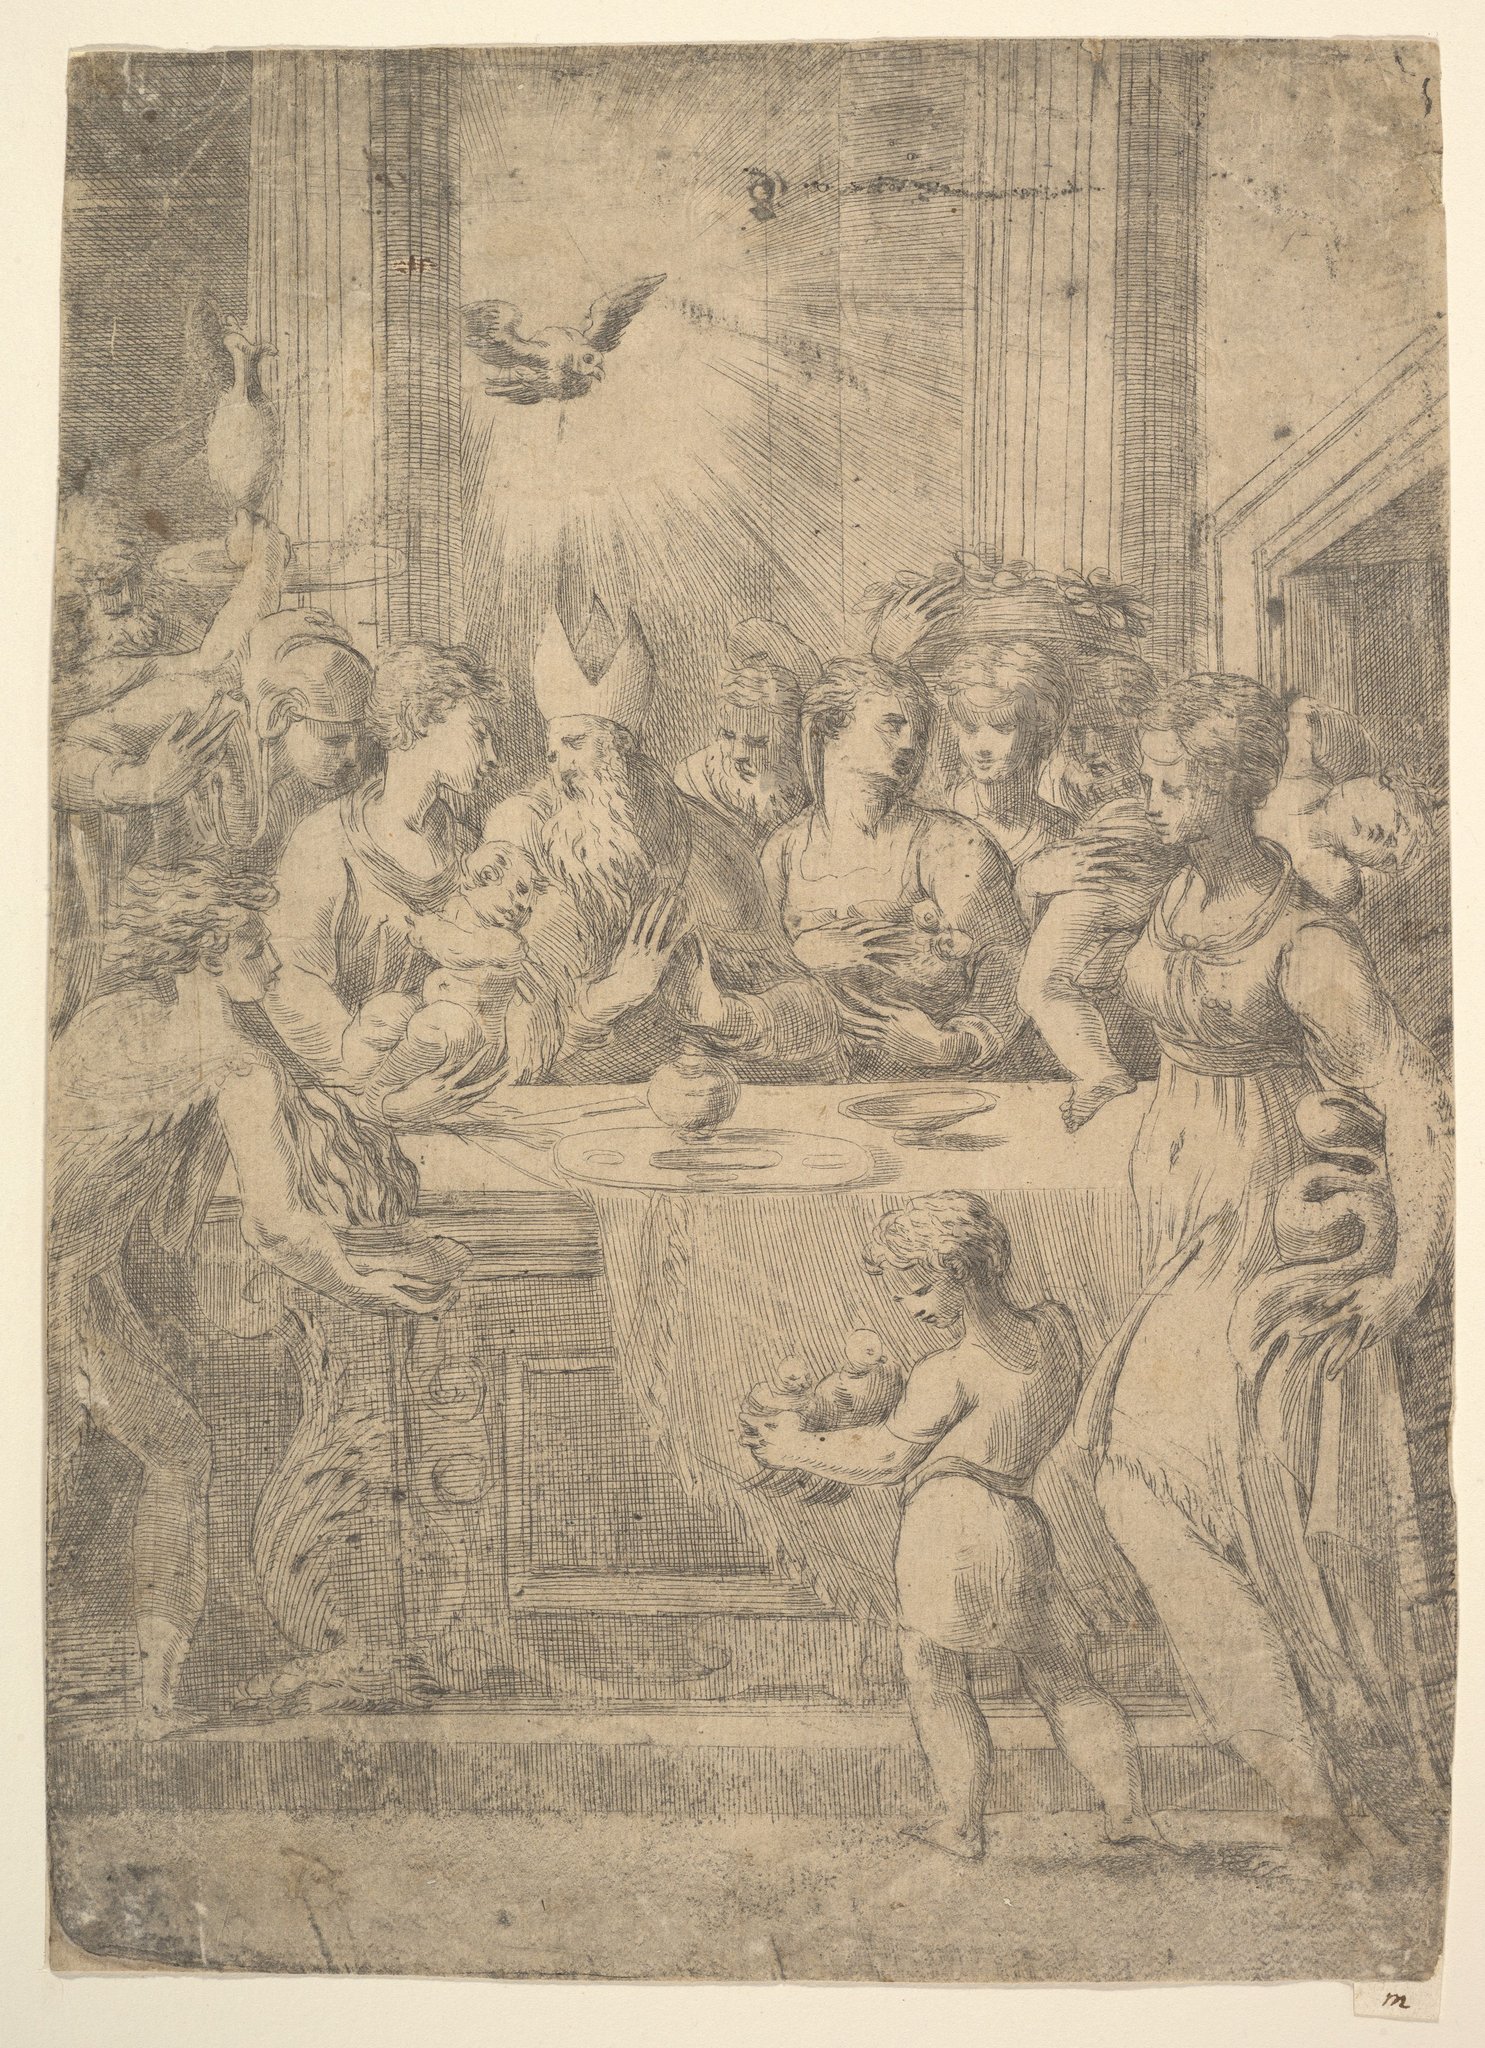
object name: print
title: The presentation of Christ in the temple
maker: andrea schiavone (andrea meldola)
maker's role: artist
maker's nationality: italian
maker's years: 1510-1563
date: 1543-1546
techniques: etching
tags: temples,men,women,christ